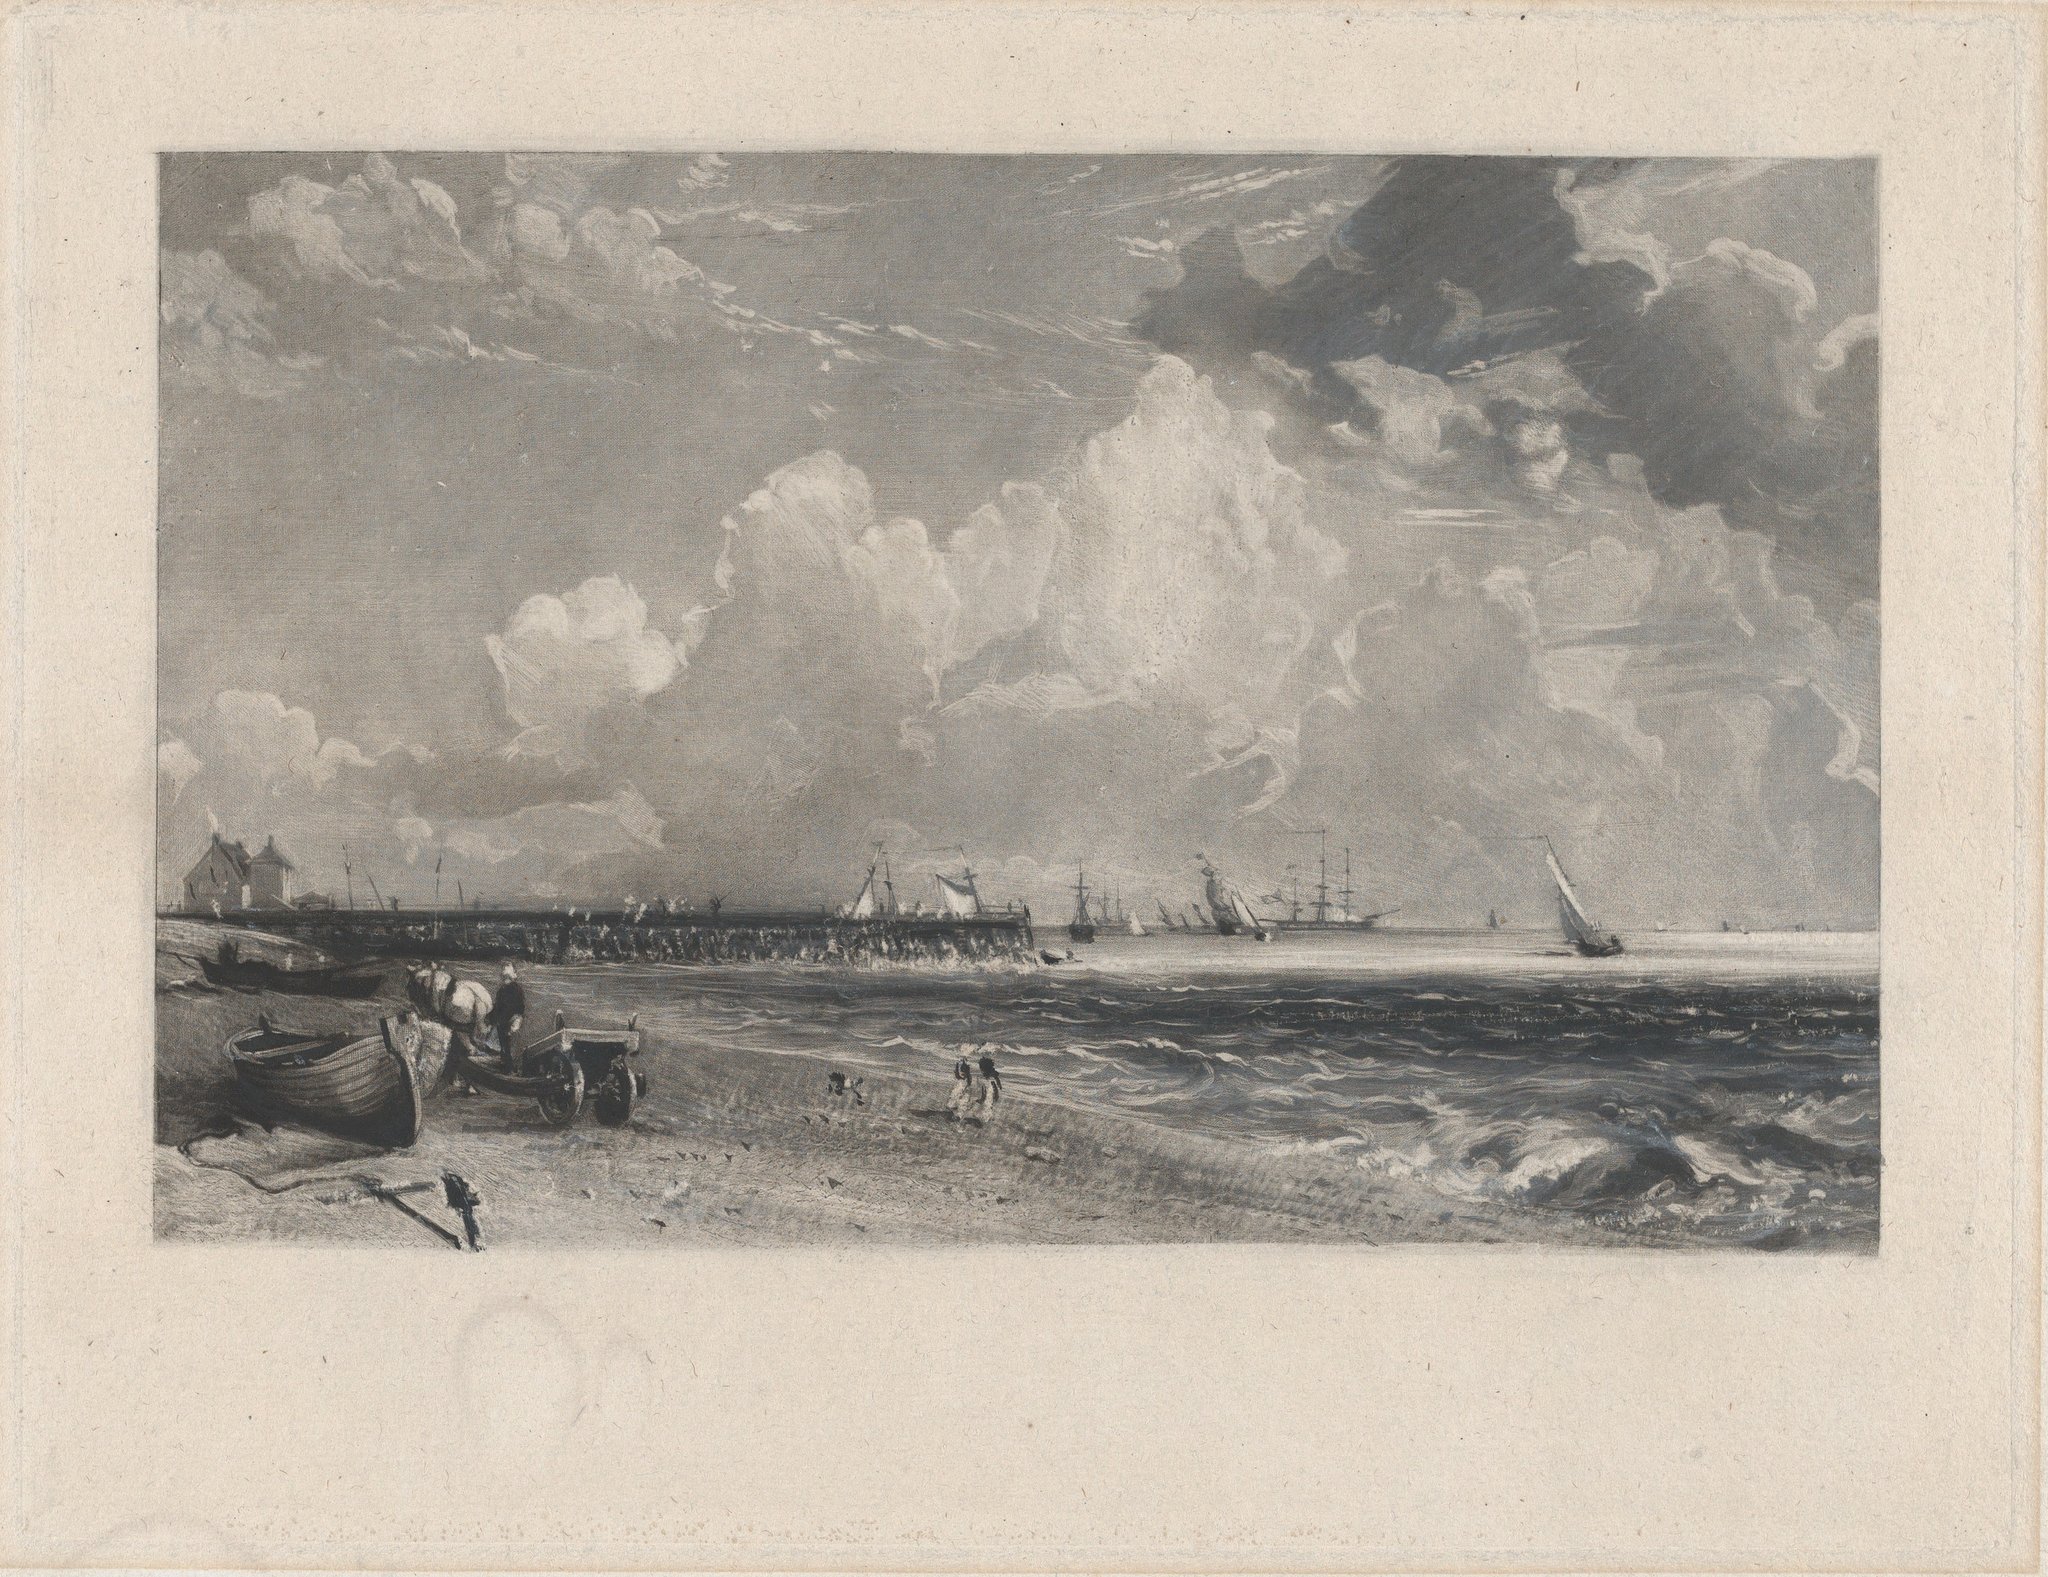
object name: print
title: Yarmouth, Norfolk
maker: david lucas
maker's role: artist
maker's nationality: british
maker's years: 1802-1881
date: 1830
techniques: mezzotint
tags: seascapes,boats,piers